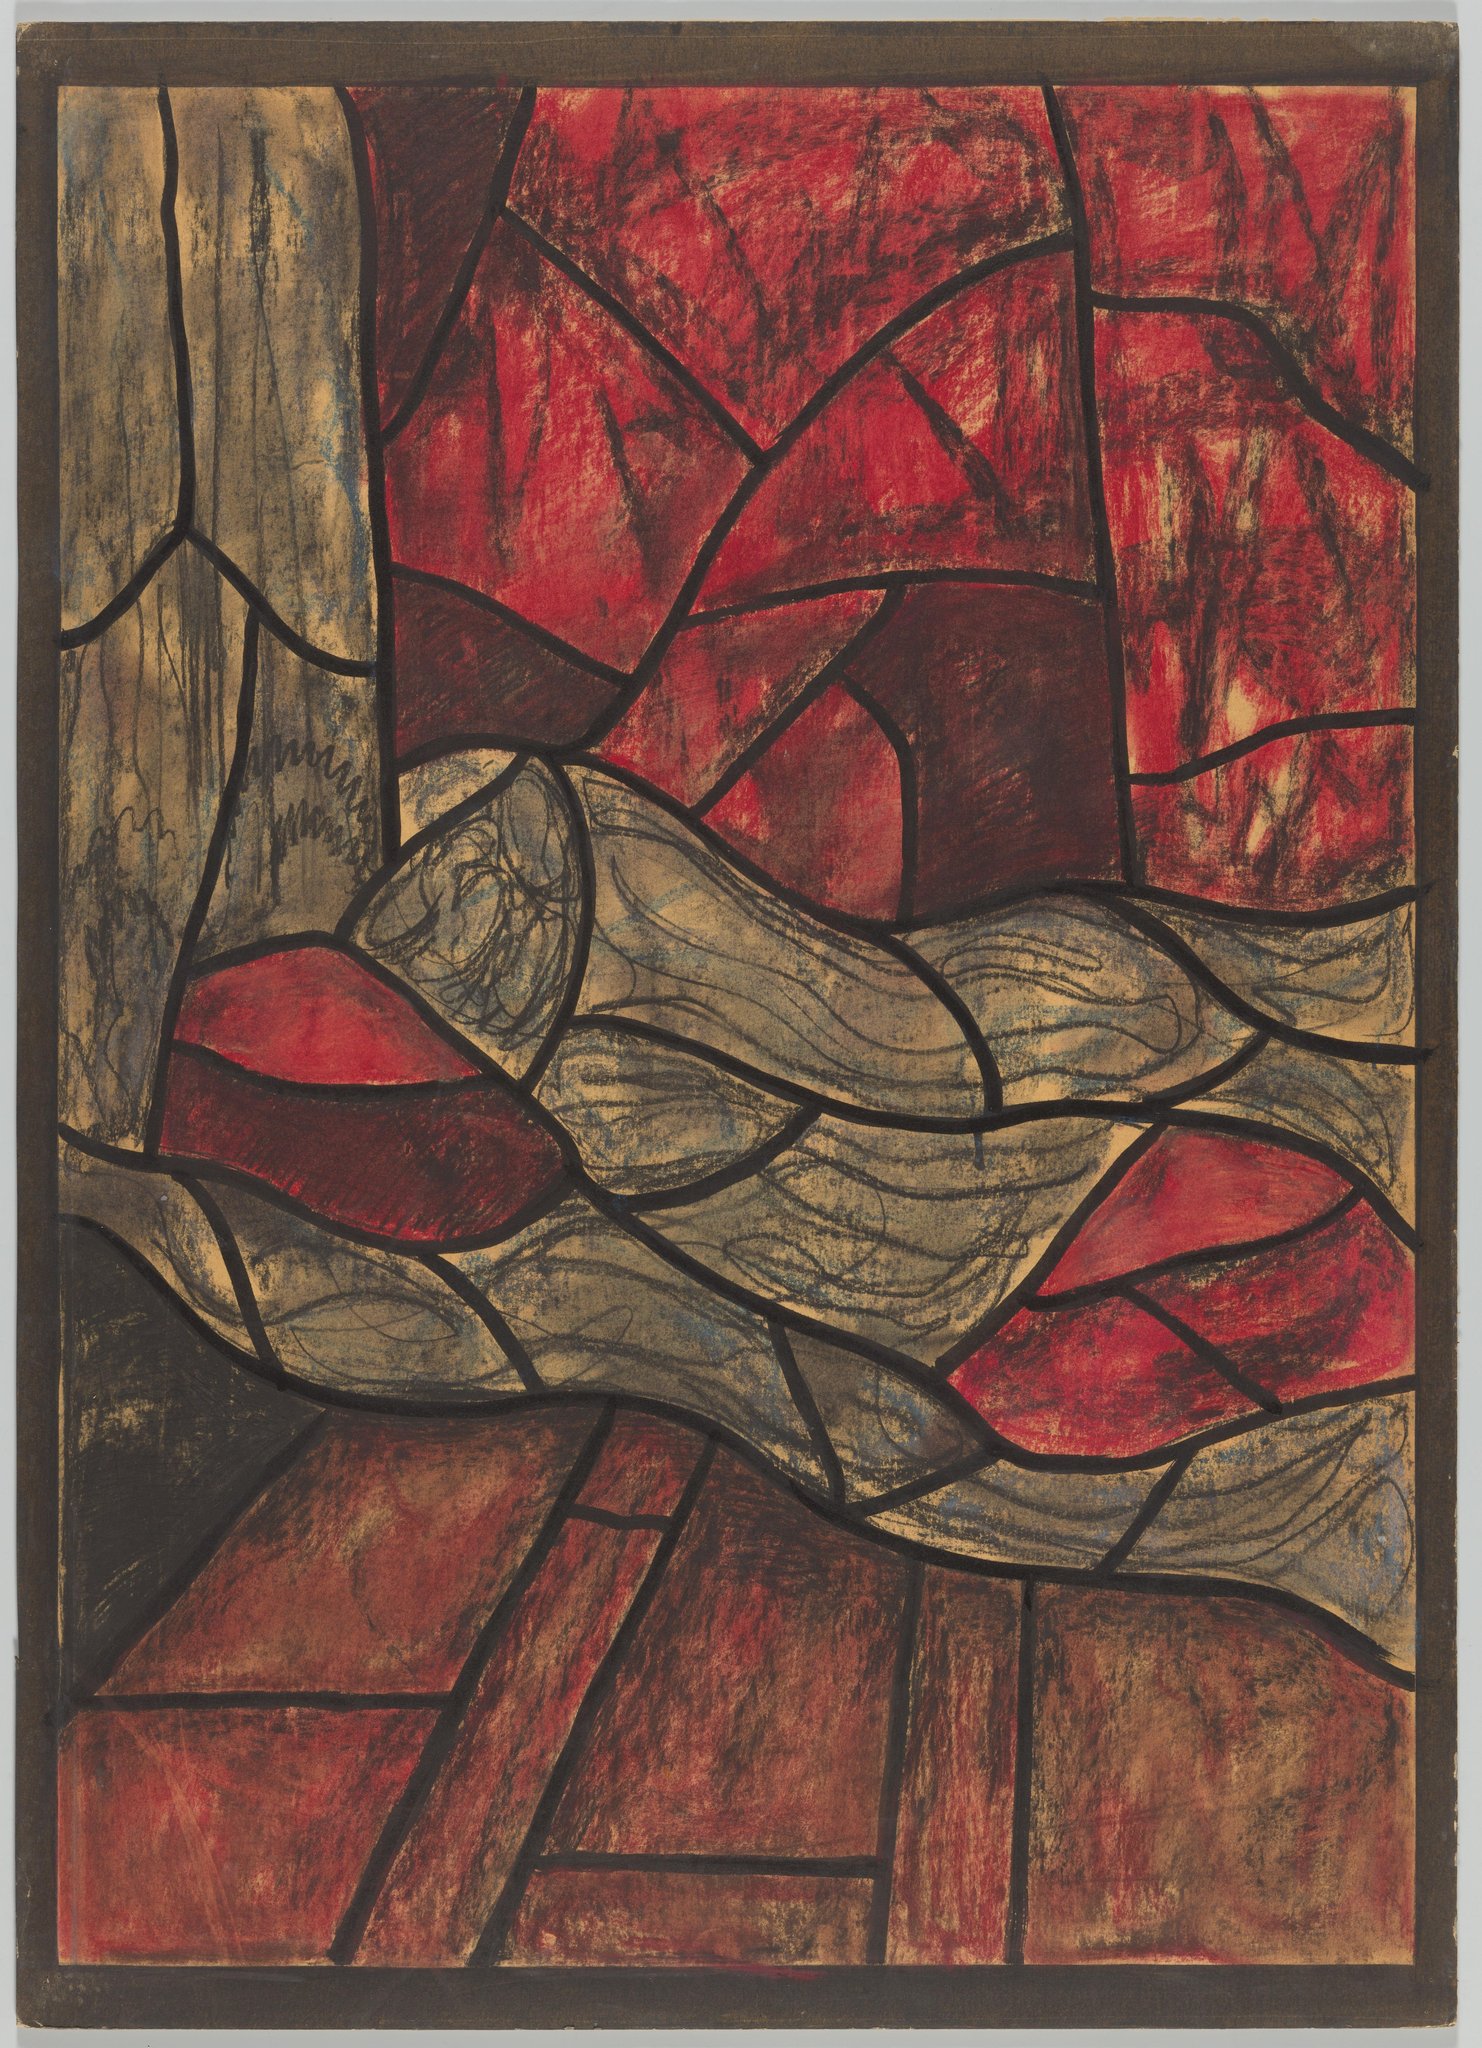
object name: design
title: Ontwerp voor raam in het Noordertransept in de Dom te Utrecht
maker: richard nicolaüs roland holst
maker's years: 1868-1938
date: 1934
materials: cardboard, chalk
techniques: brush